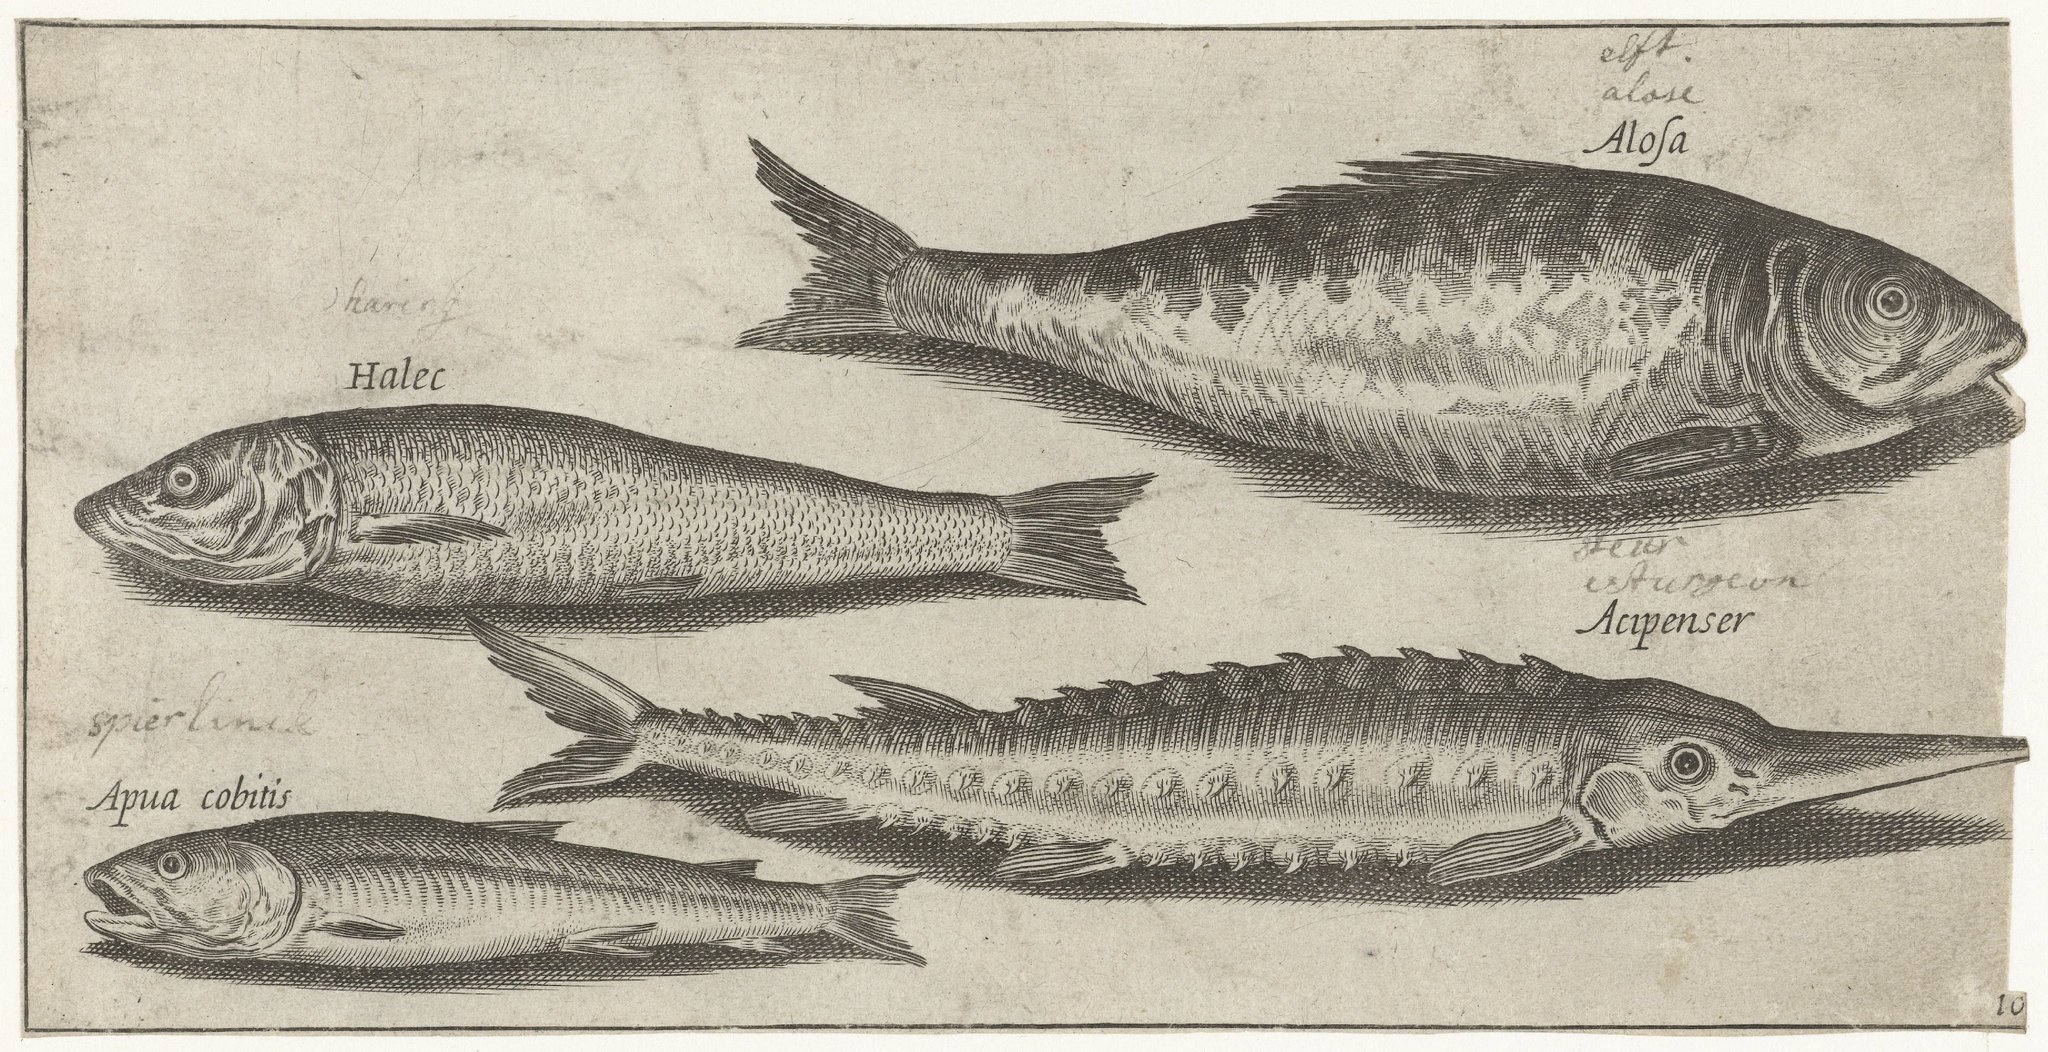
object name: print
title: Vissen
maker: pierre firens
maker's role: print maker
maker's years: 1580-1638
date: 1600-1638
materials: paper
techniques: engraving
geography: paris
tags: fishes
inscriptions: collector's mark: Lugt 2228